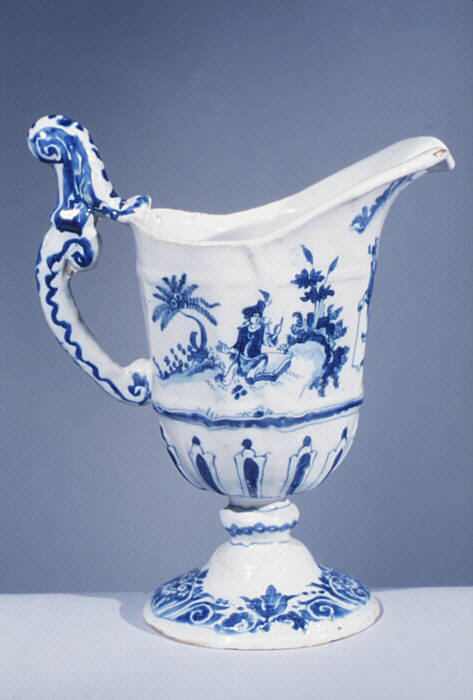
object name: ewer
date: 1700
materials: faience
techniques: glazing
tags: human figures